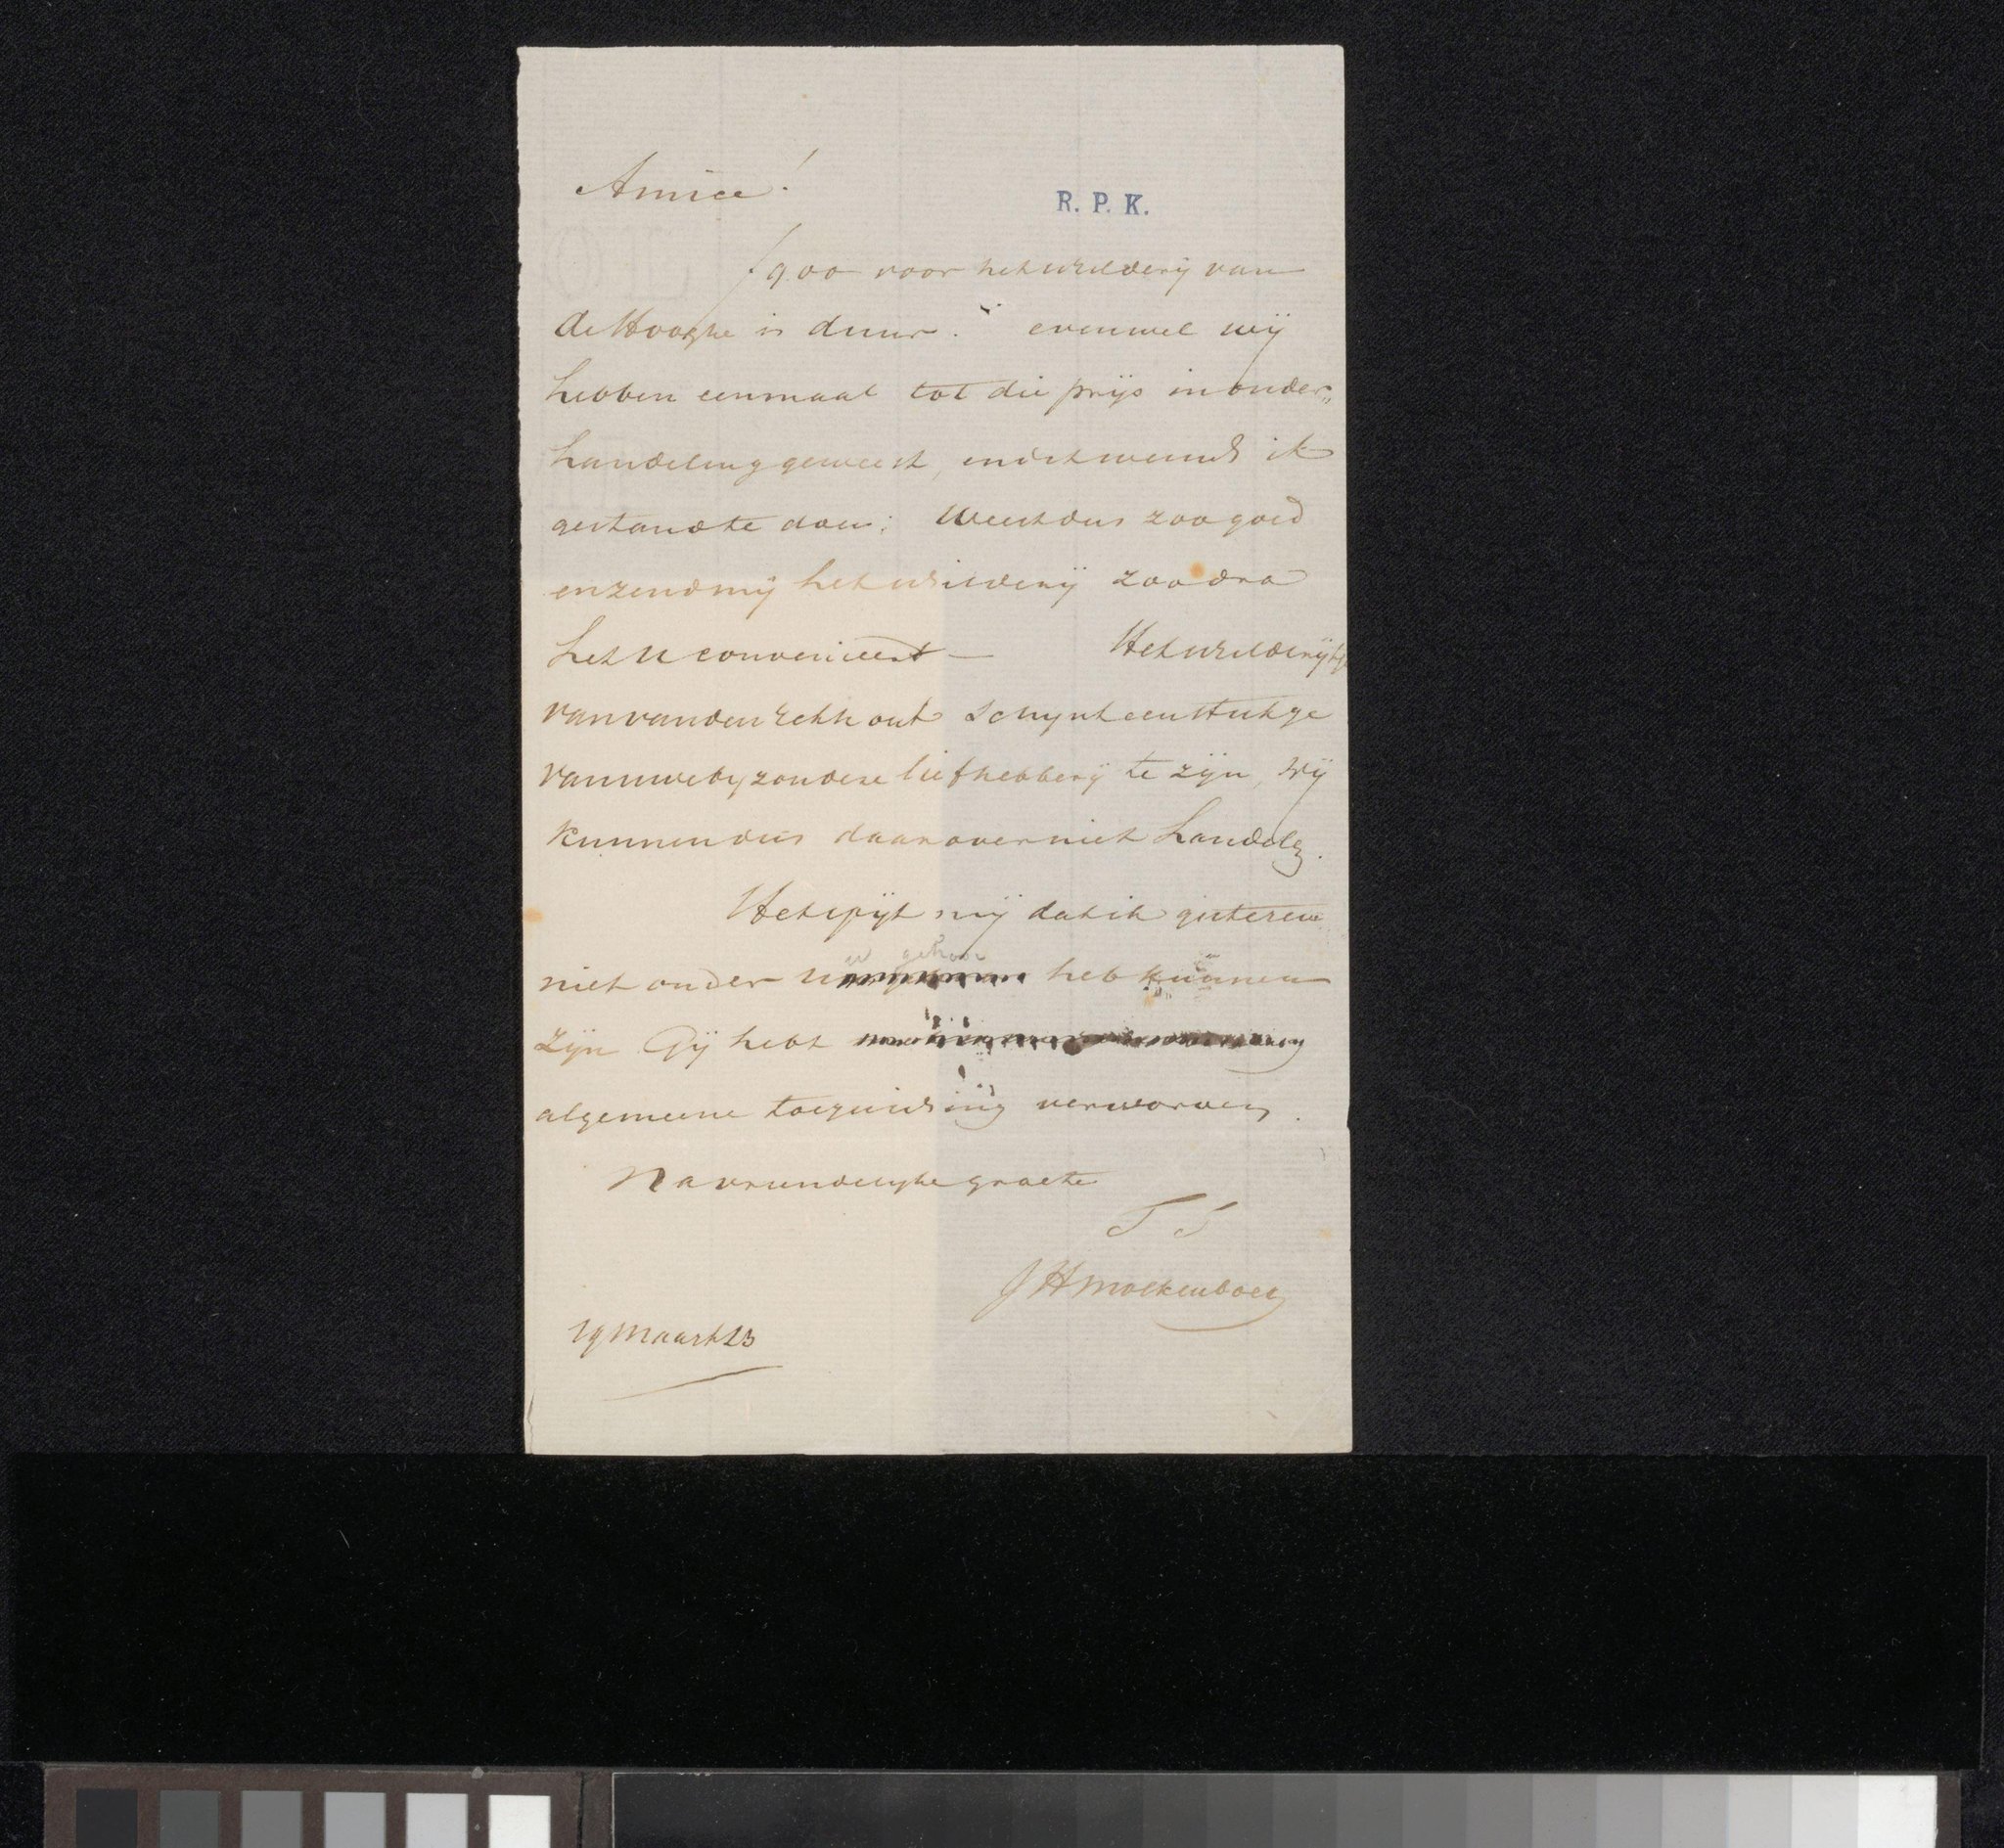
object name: letter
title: Brief aan anoniem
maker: johannes hermannus molkenboer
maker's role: kunstverzamelaar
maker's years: 1773-1824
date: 1823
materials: ink, paper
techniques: pen, writing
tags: amsterdam, print maker, draughtsman, gerbrand van den eeckhout, art trade, art shop, painting (including book-illumination, miniature-painting), money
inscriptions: collector's mark: Lugt 2233, watermark